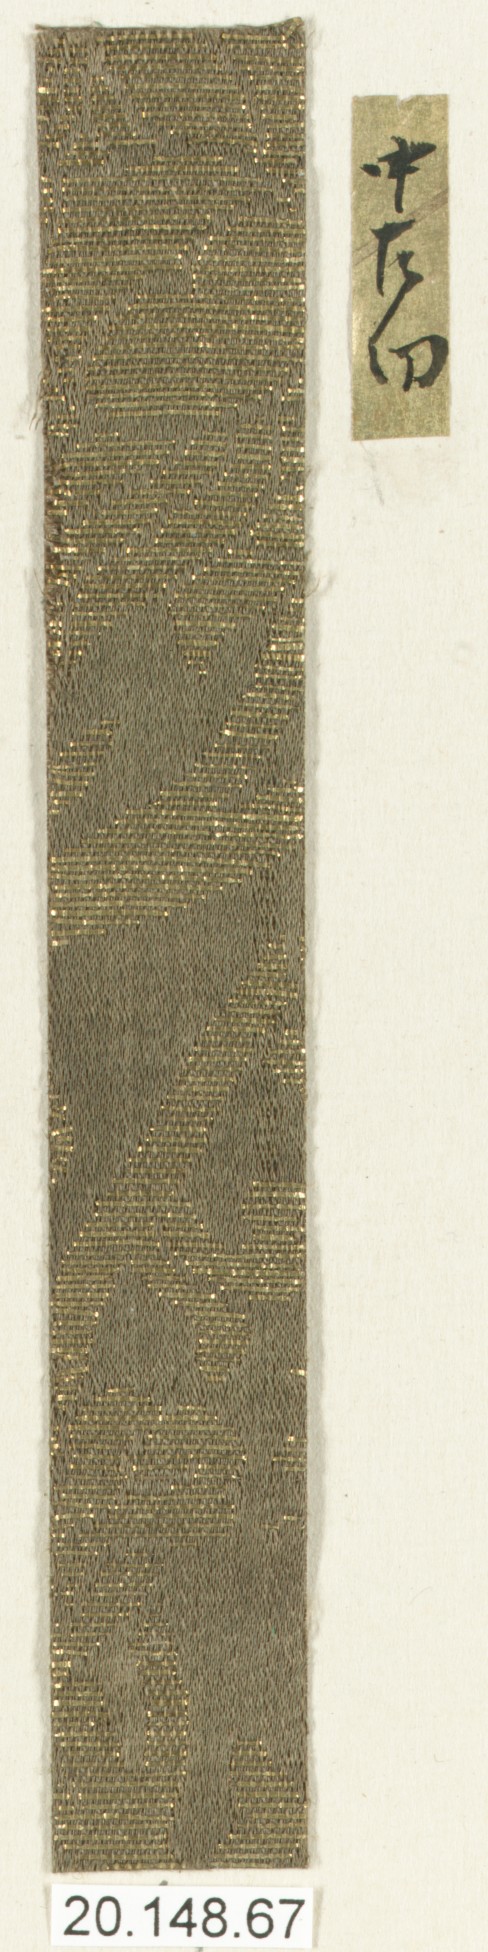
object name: piece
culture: japanese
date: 1501-1600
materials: silk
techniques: compound weave